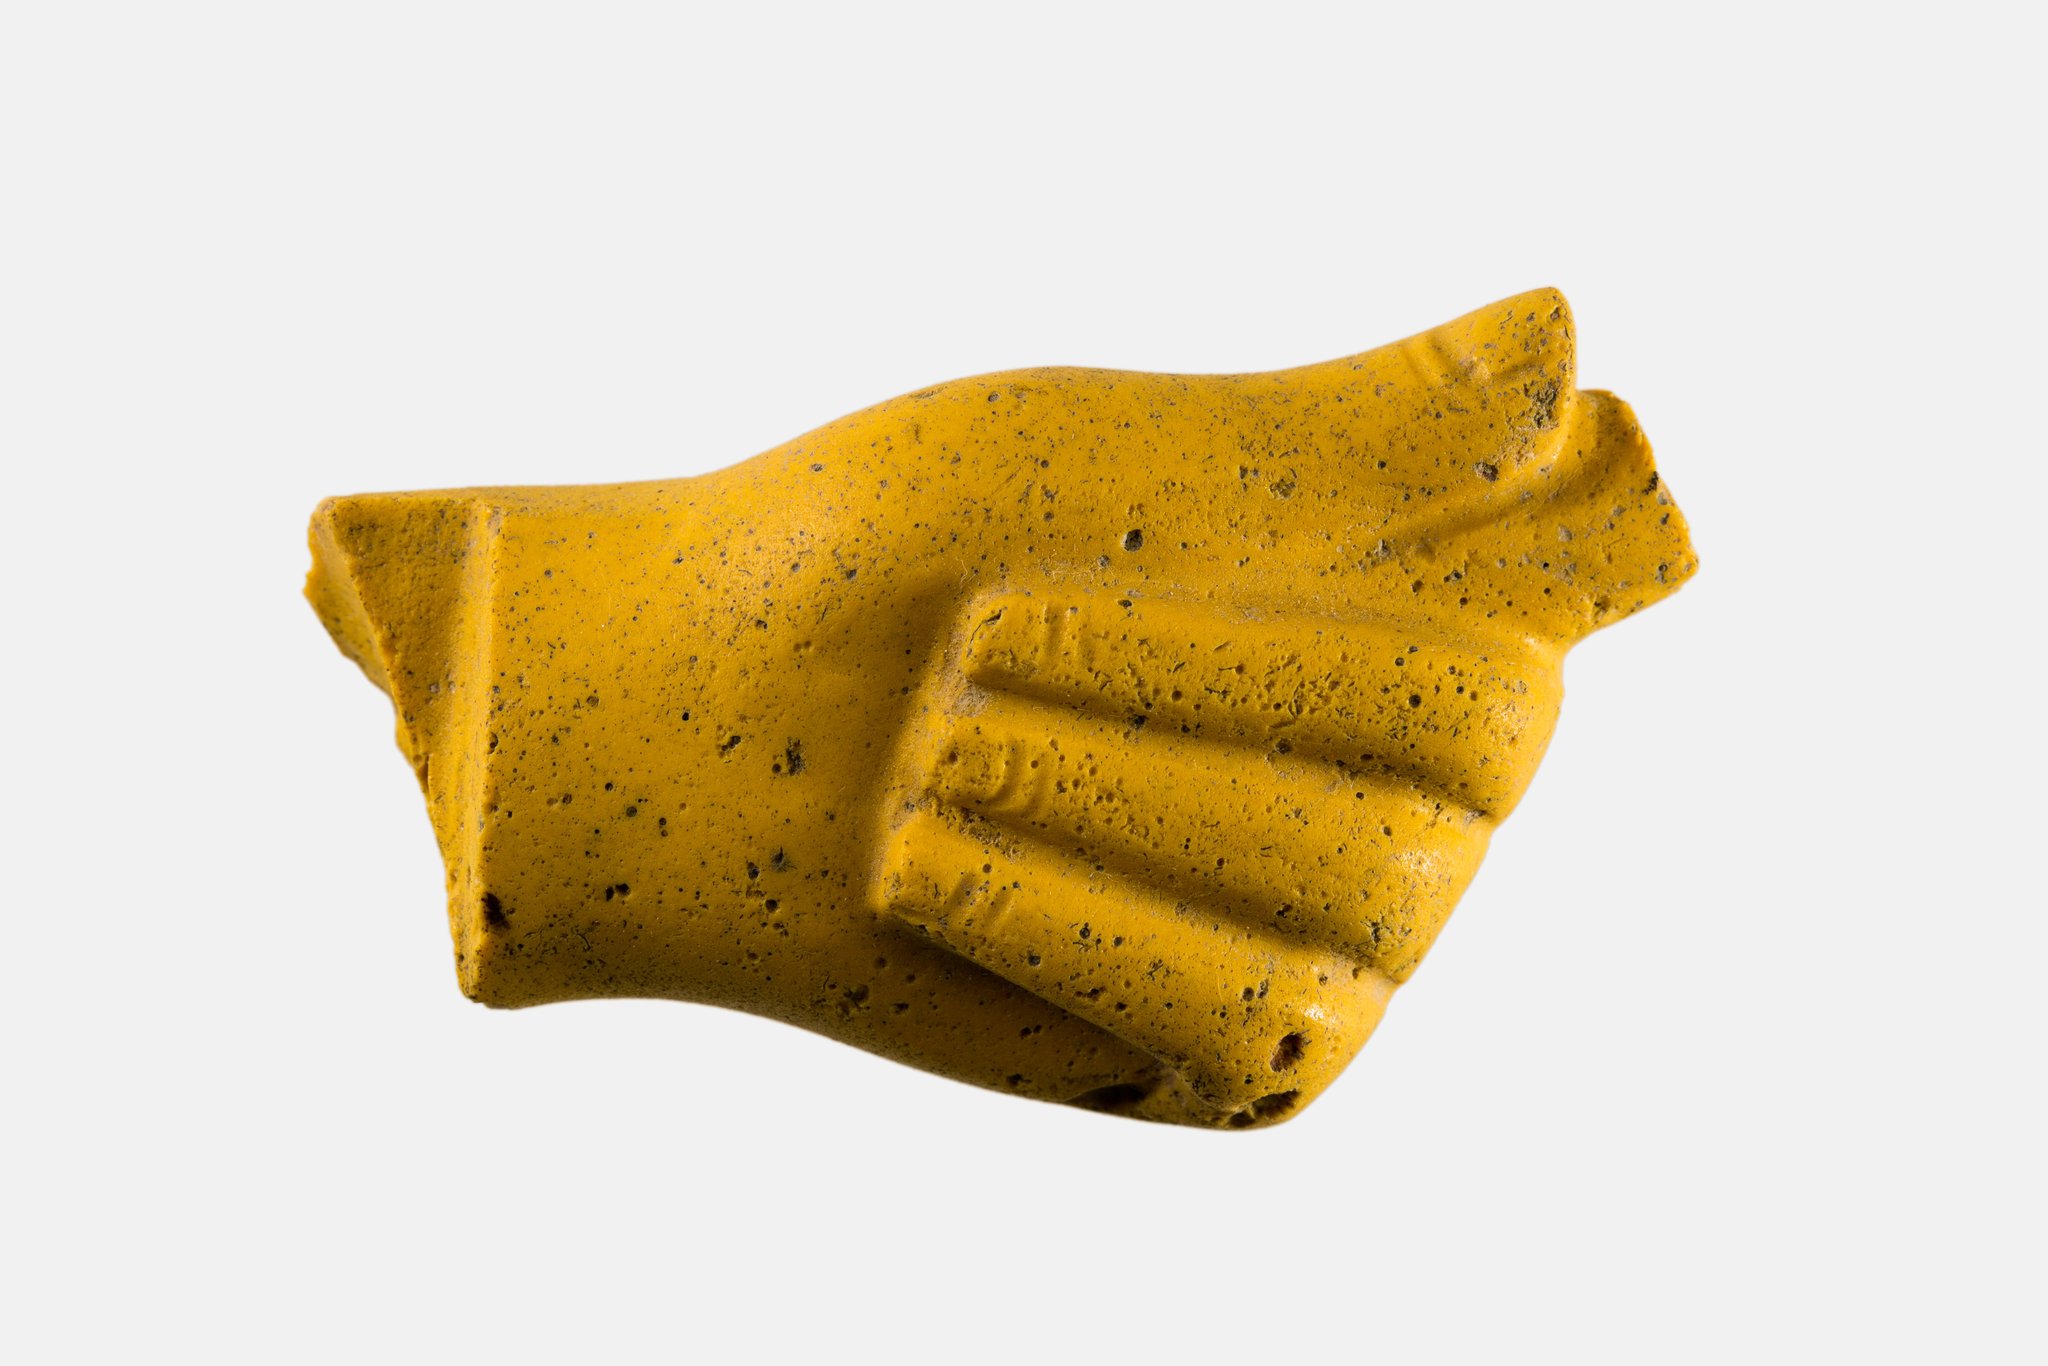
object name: inlay, fist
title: Fist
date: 664-630 BCE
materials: glass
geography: egypt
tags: hands